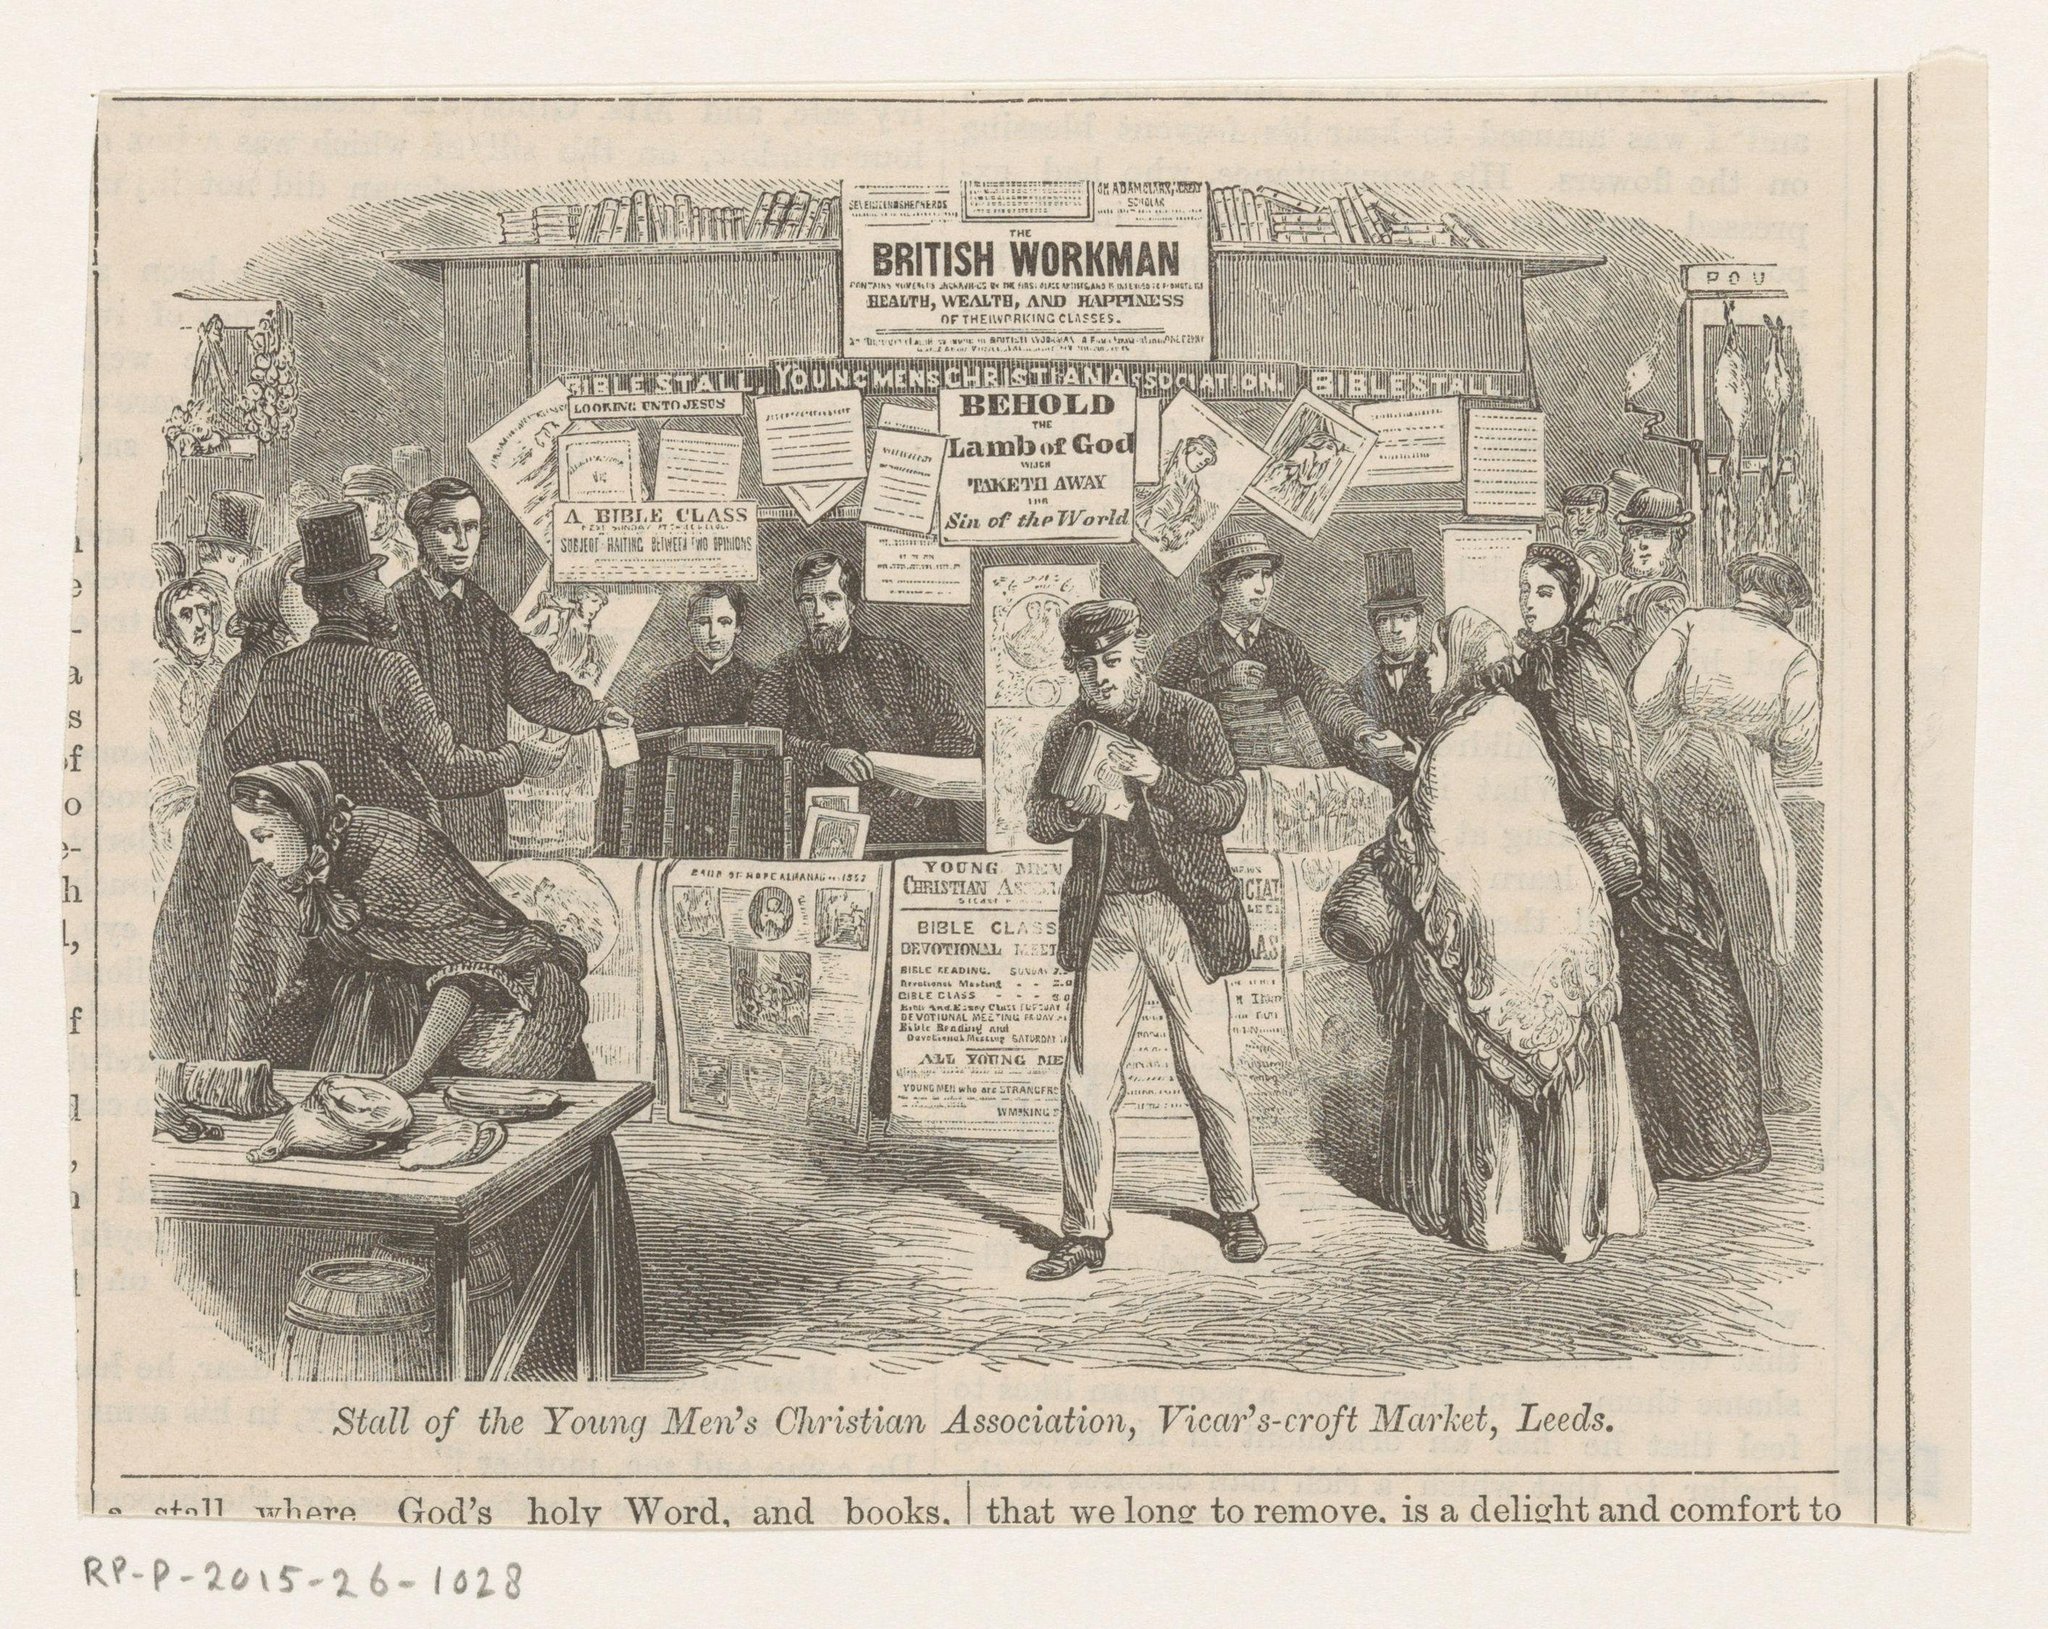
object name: print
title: Stall of the Young Men's Chrisitan Association, Vicar's-croft Market, Leeds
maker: Anonymous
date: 1850-1875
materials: paper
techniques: engraving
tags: book-stall, kiosk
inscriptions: collector's mark: Lugt 4779, collector's mark: Lugt 2228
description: Waarschijnlijk een illustratie uit een boek of tijdschrift.